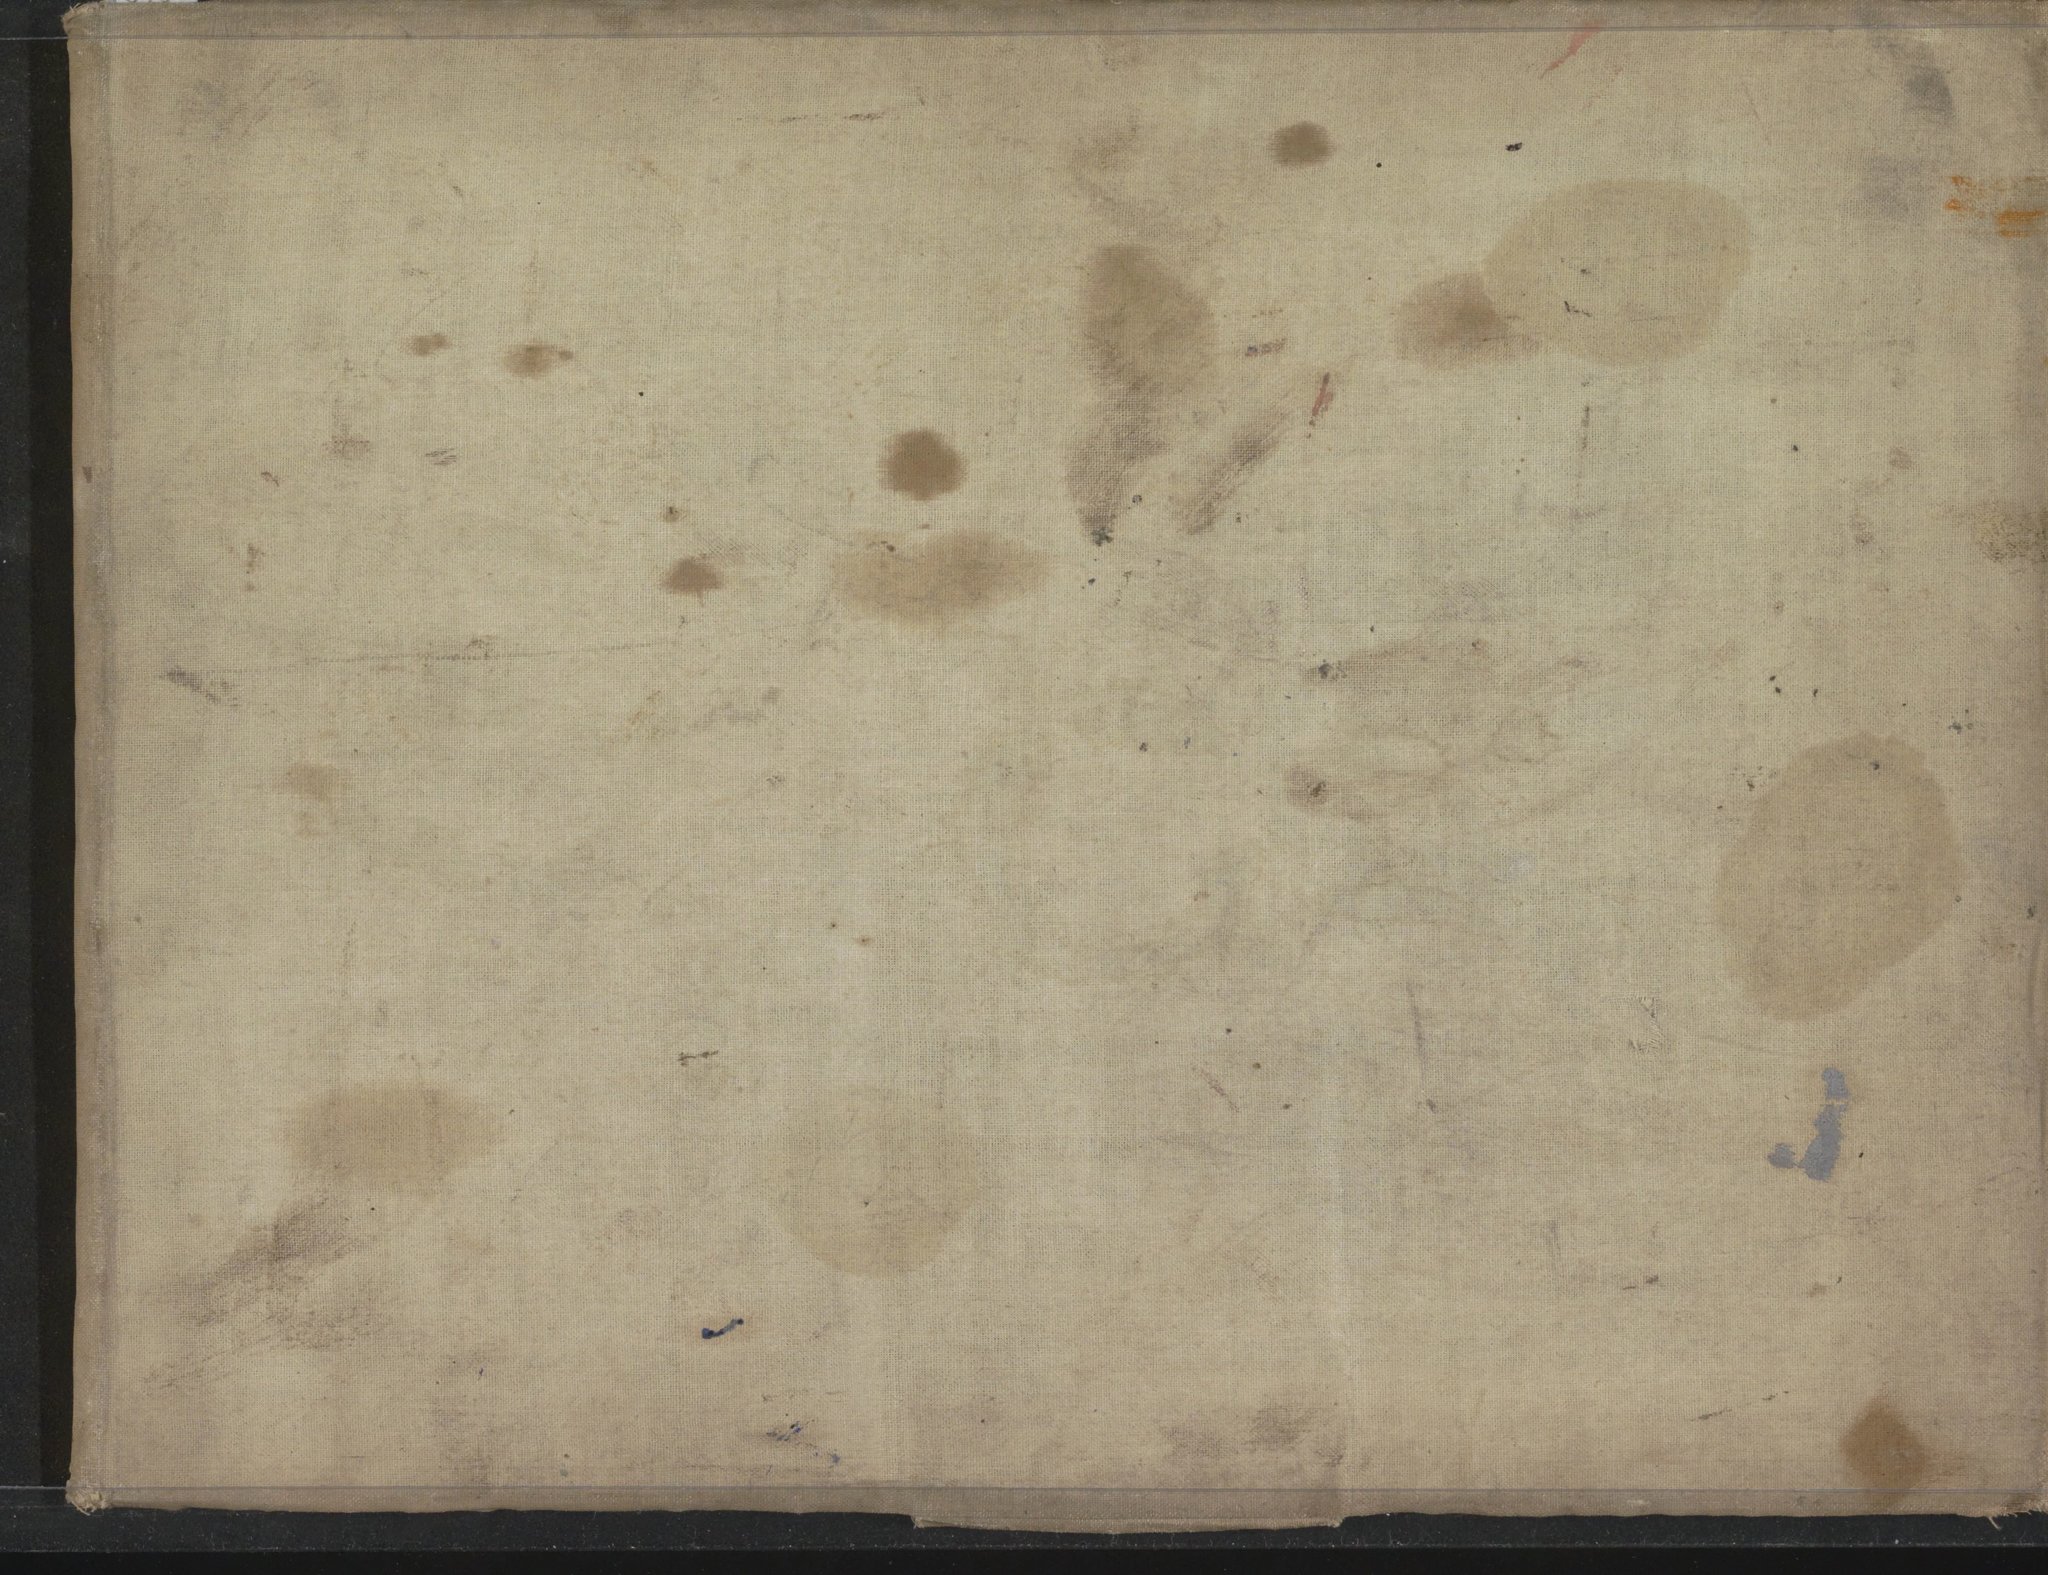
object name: sketchbook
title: Schetsboek met 22 bladen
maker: cornelis vreedenburgh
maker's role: draughtsman, print maker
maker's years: 1880-1946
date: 1890-1946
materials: cardboard, chalk, linen, paper, pencil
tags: sailing-ship, sailing-boat, animals, landscapes (+ landscape with figures, staffage)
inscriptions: annotation: ‘Va[...] Schu[...]/ [...]K[...]ag’, collector's mark: Lugt 2228a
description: De volgende bladen uit het schetsboek zijn blanco: 1, 2(R), 3(V), 4(V), 5 t/m 18, 20(R) t/m 22(R).